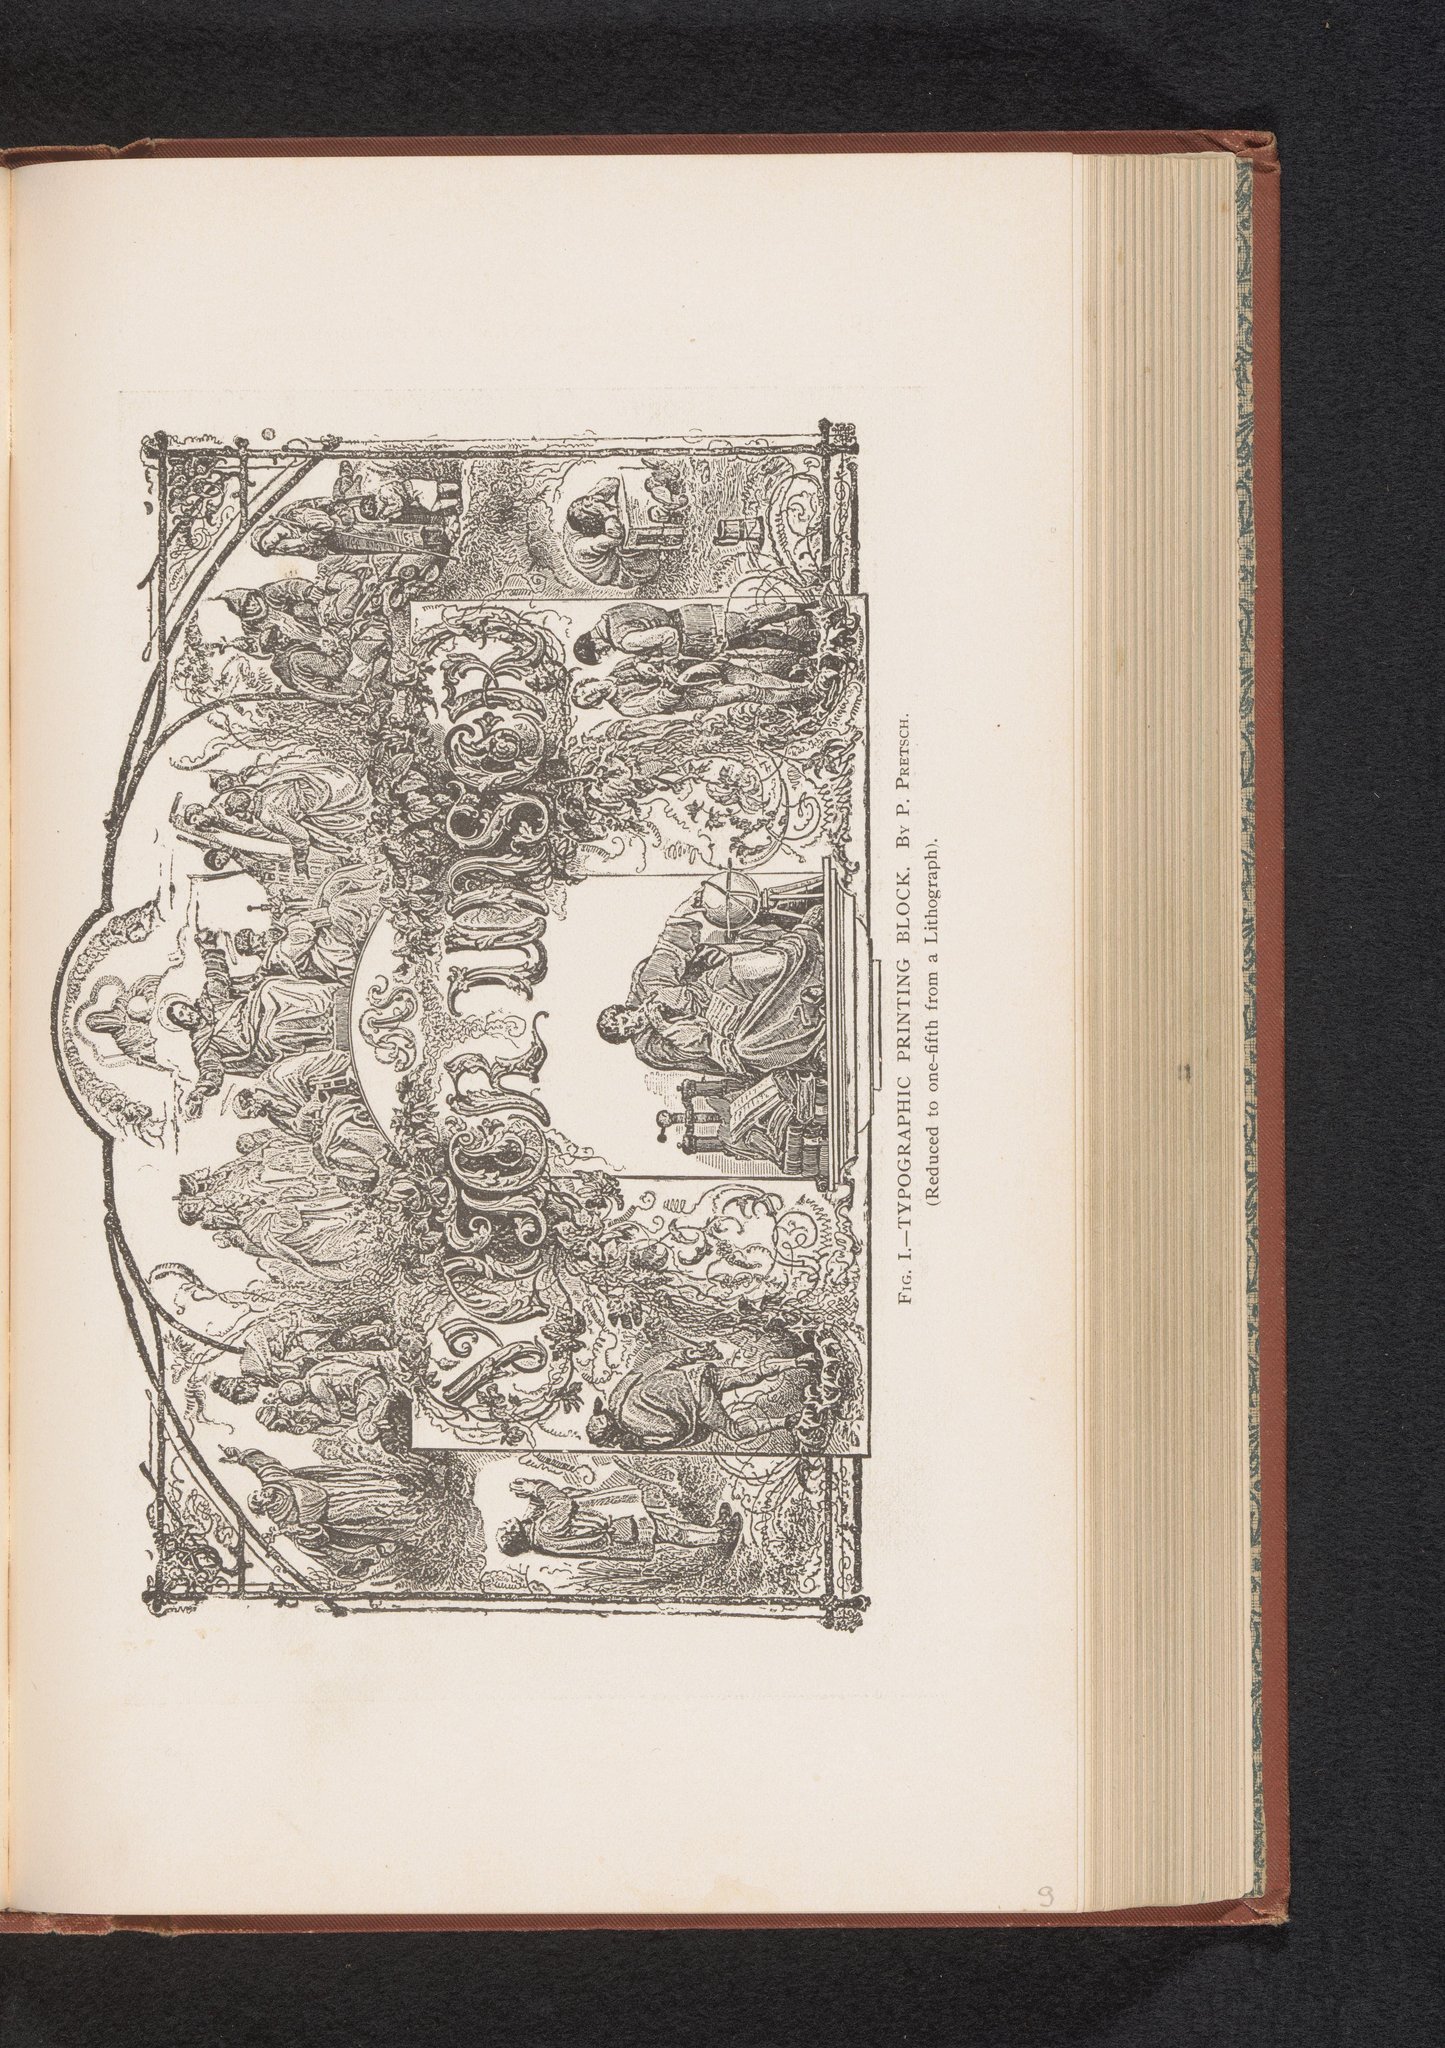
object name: photomechanical print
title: Reproductie van een prent van een christelijke voorstelling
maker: paul pretsch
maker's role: printer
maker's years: 1808-1873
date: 1884-1889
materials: paper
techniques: photochemical processes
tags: new testament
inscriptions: inscription: ‘(Reduced to one-fifth from a Lithograph).’, inscription: ‘Fig. I. - Typographic Printing Block’